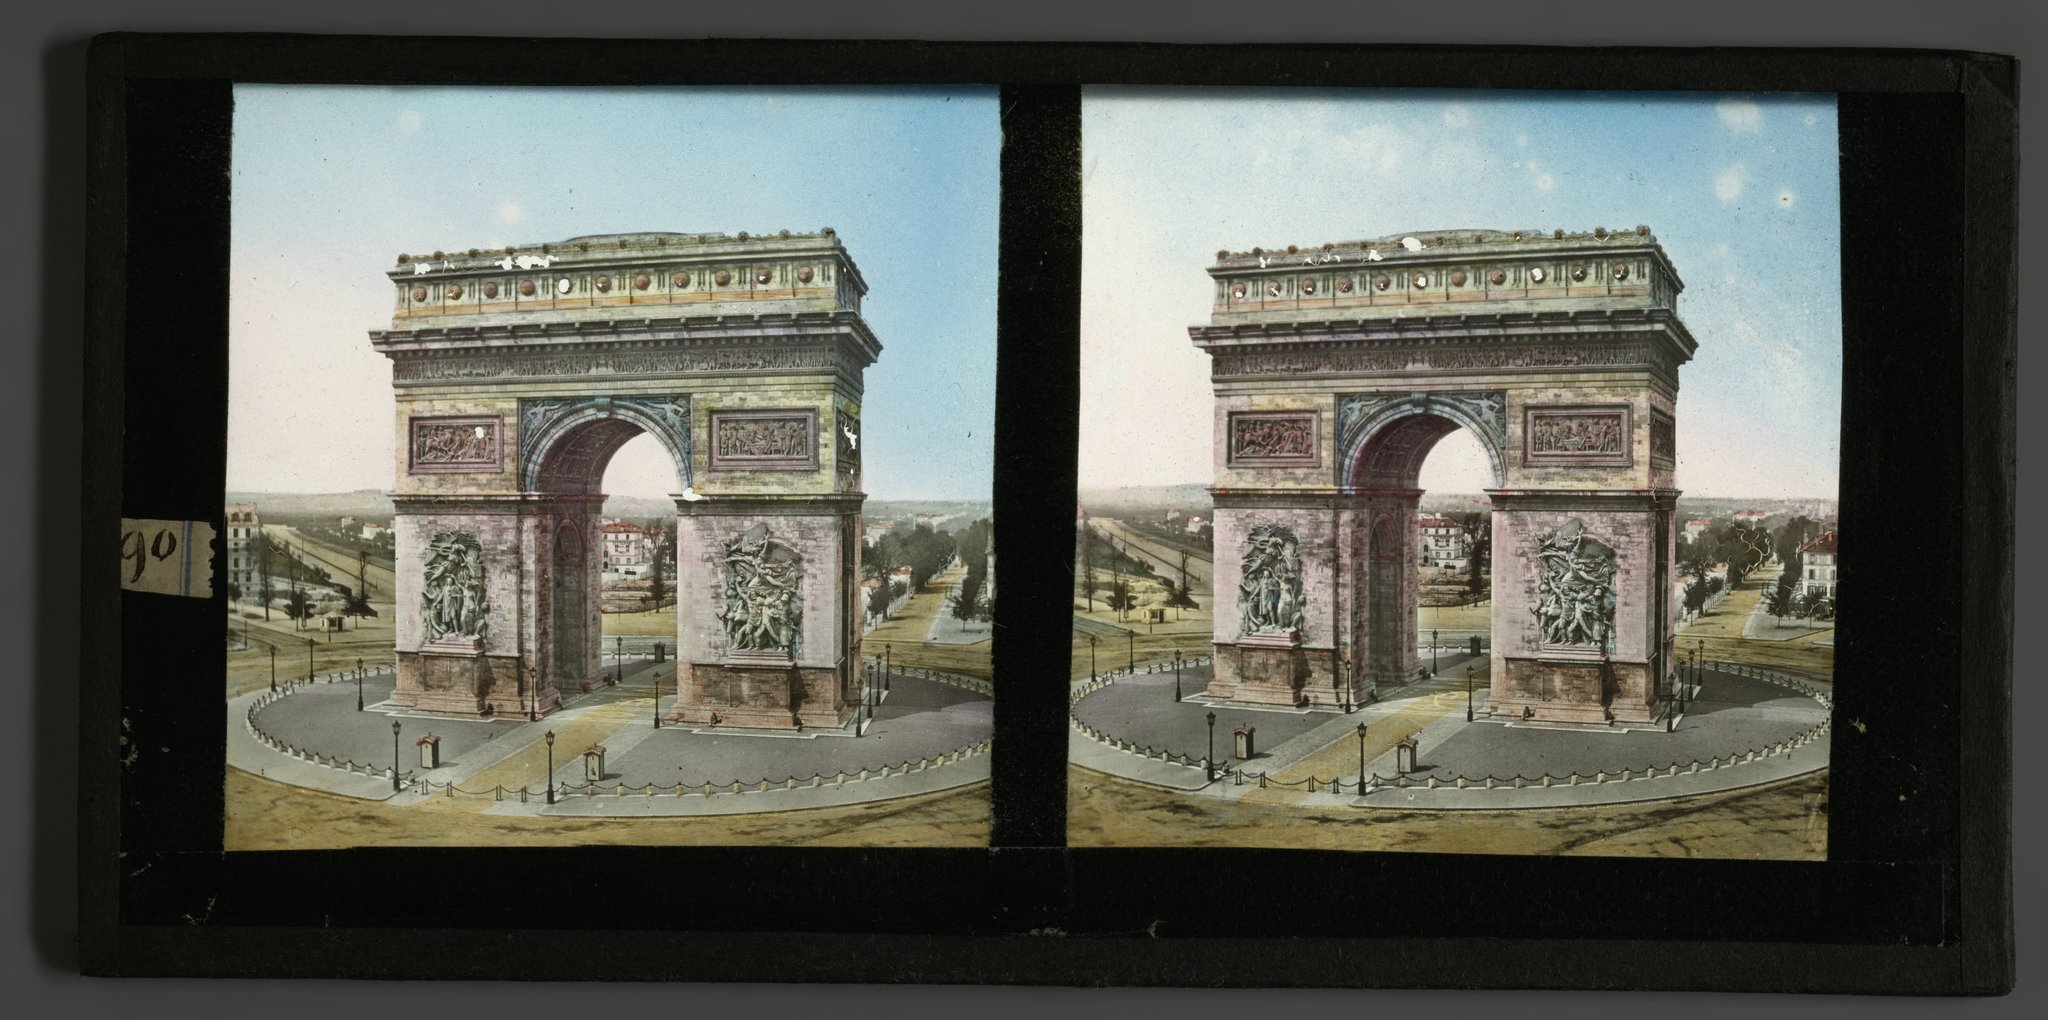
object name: stereoscopic photograph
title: Gezicht op de Arc de Triomphe in Parijs, Frankrijk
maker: Anonymous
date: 1856-1890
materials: glass, paper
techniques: hand coloring, slide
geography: paris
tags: triumphal arch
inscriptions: number: ‘90’